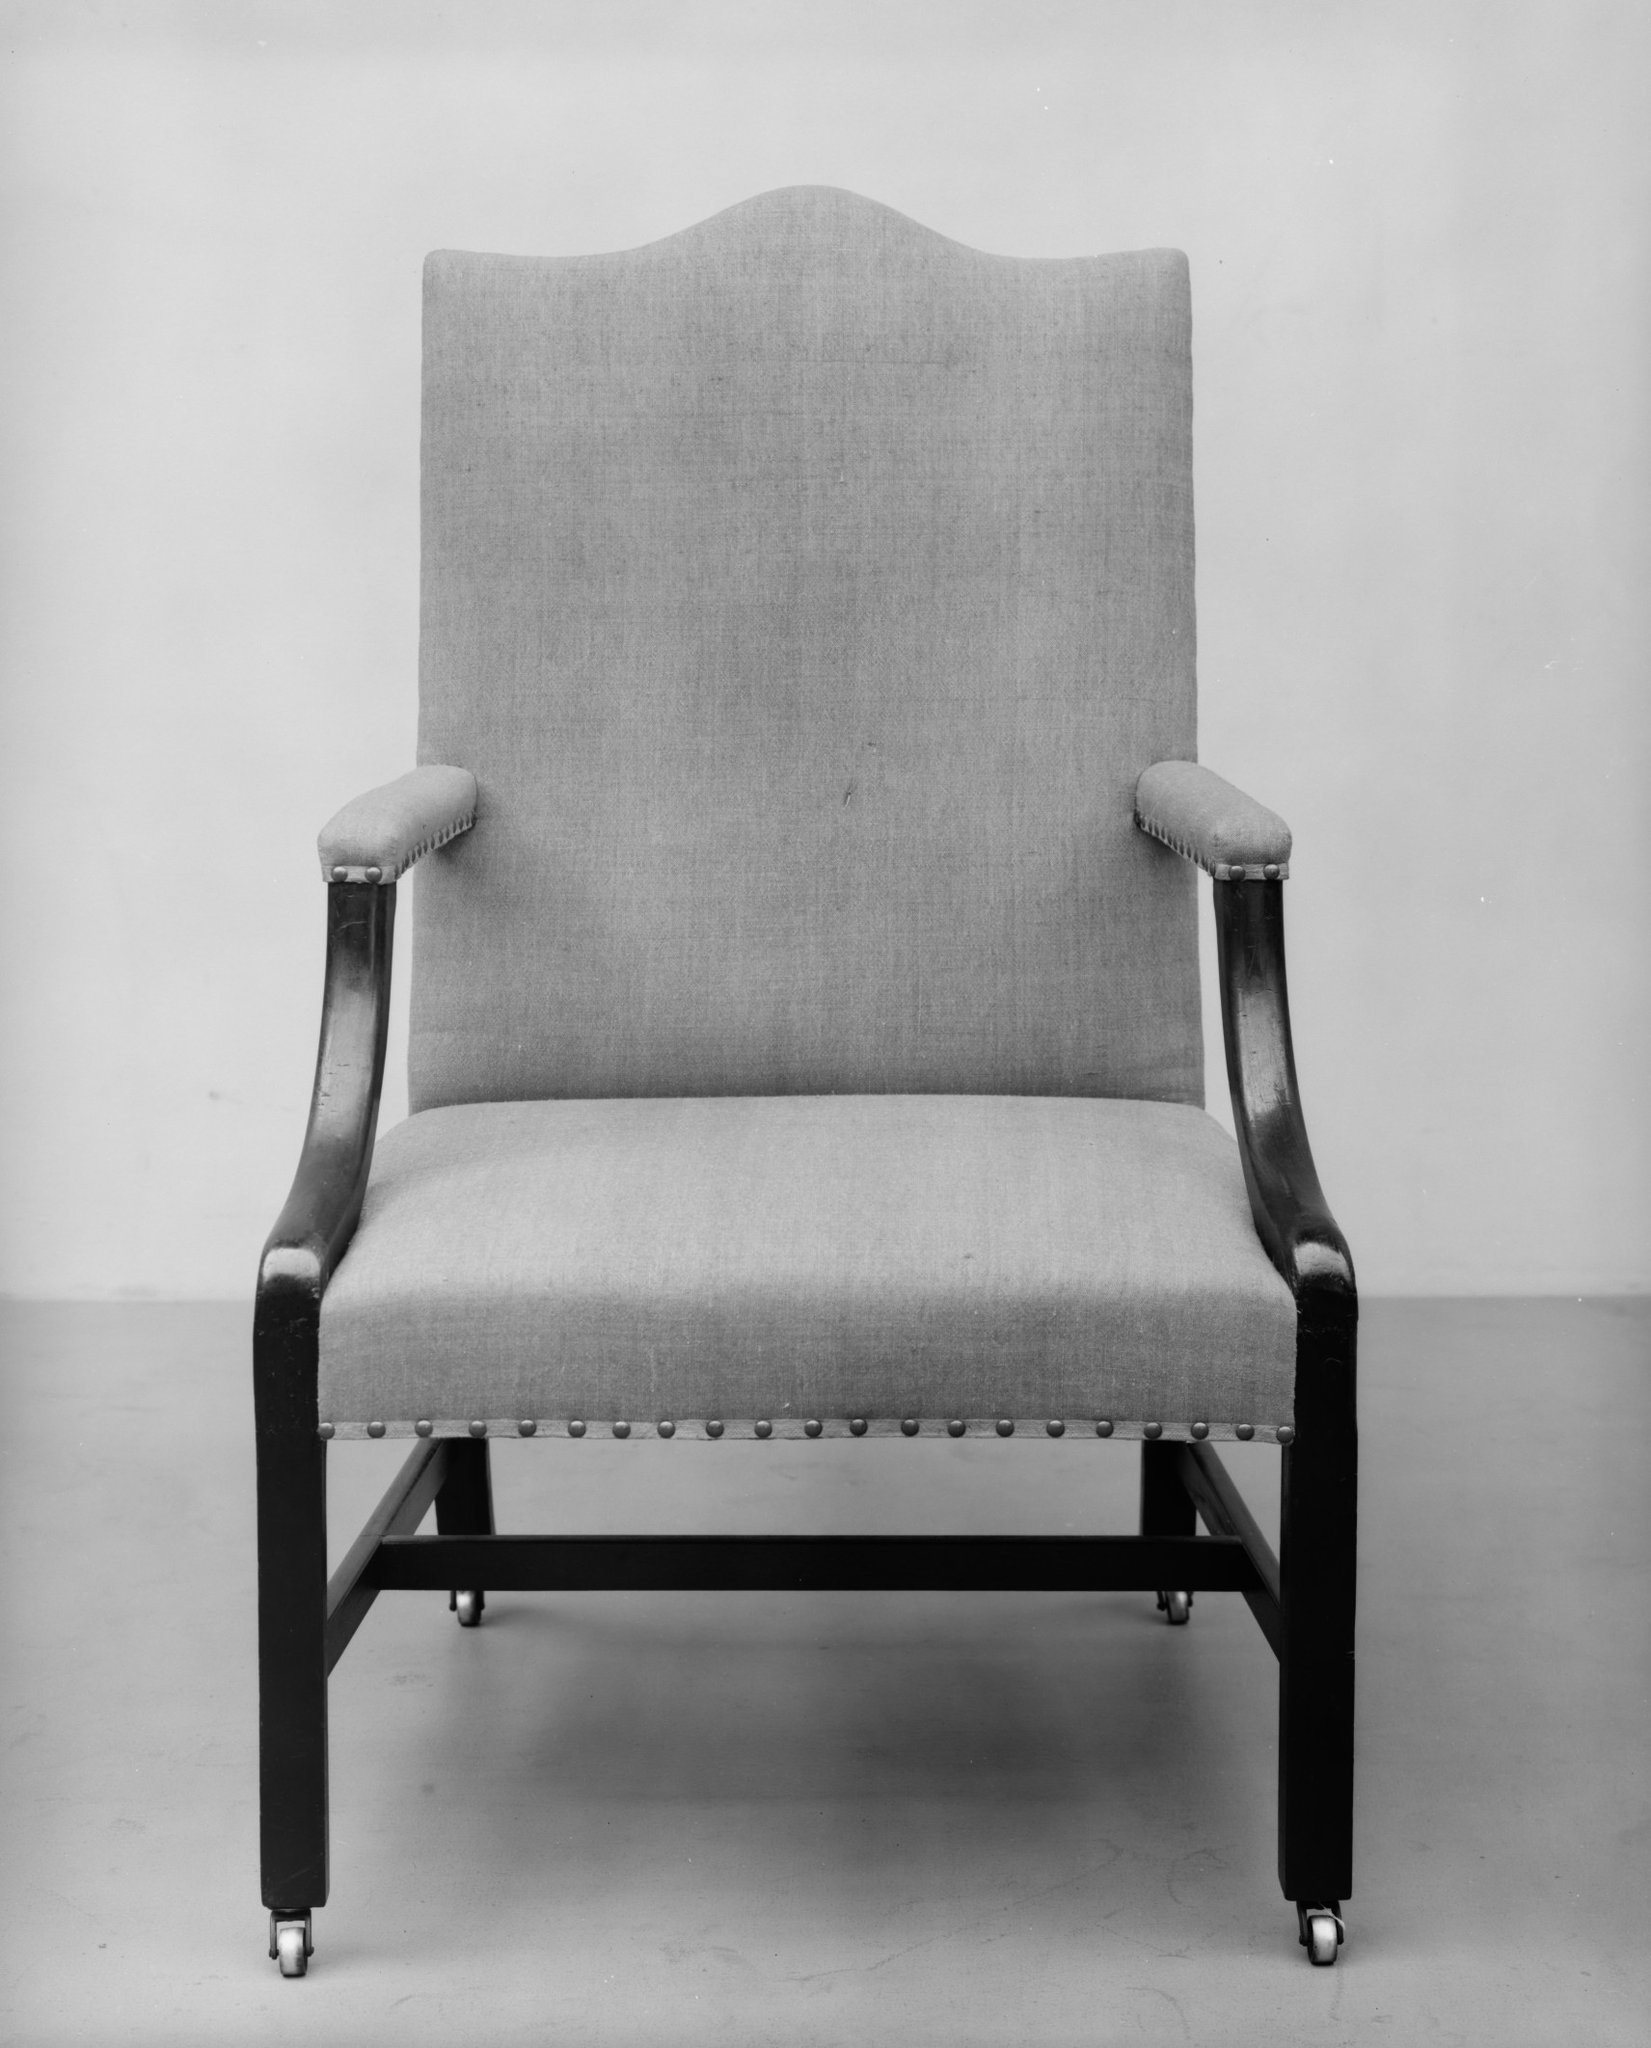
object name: armchair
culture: american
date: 1755-1790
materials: wood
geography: united states